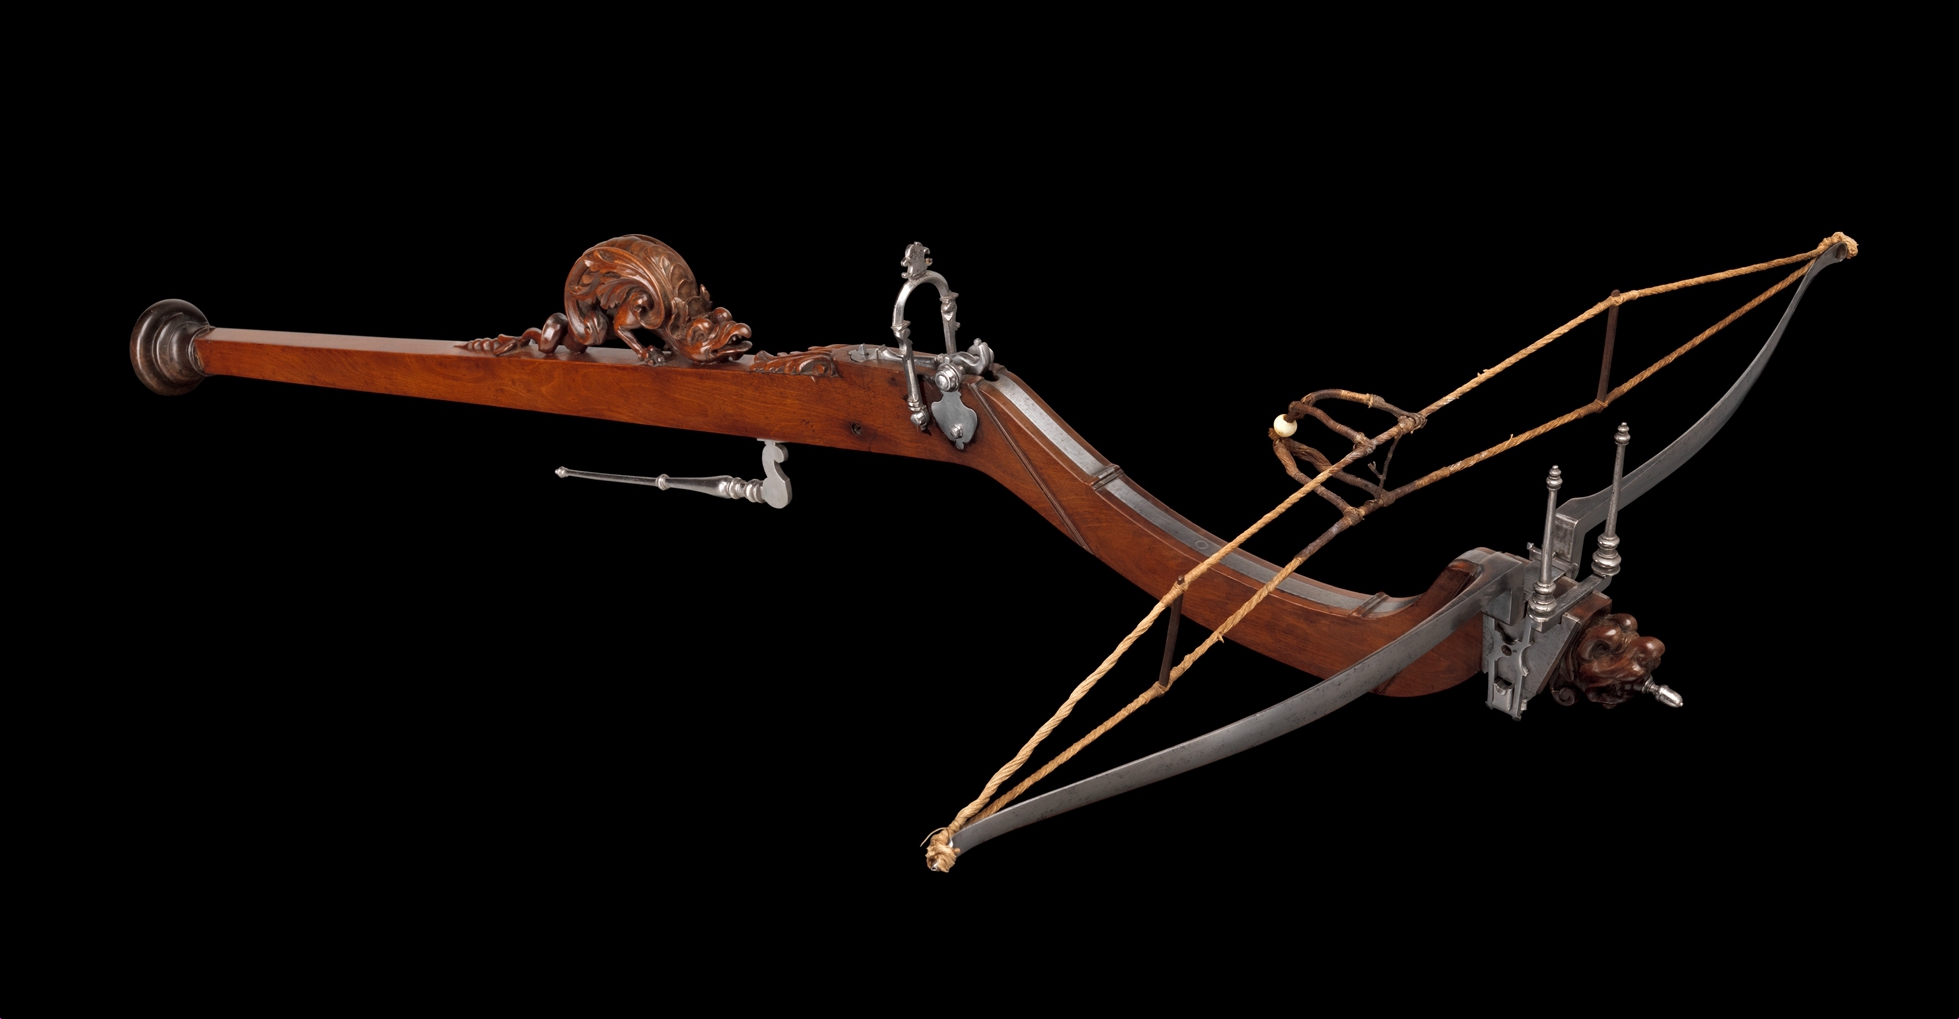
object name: pellet crossbow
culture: french or italian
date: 1550-1600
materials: hemp, steel, wood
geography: france